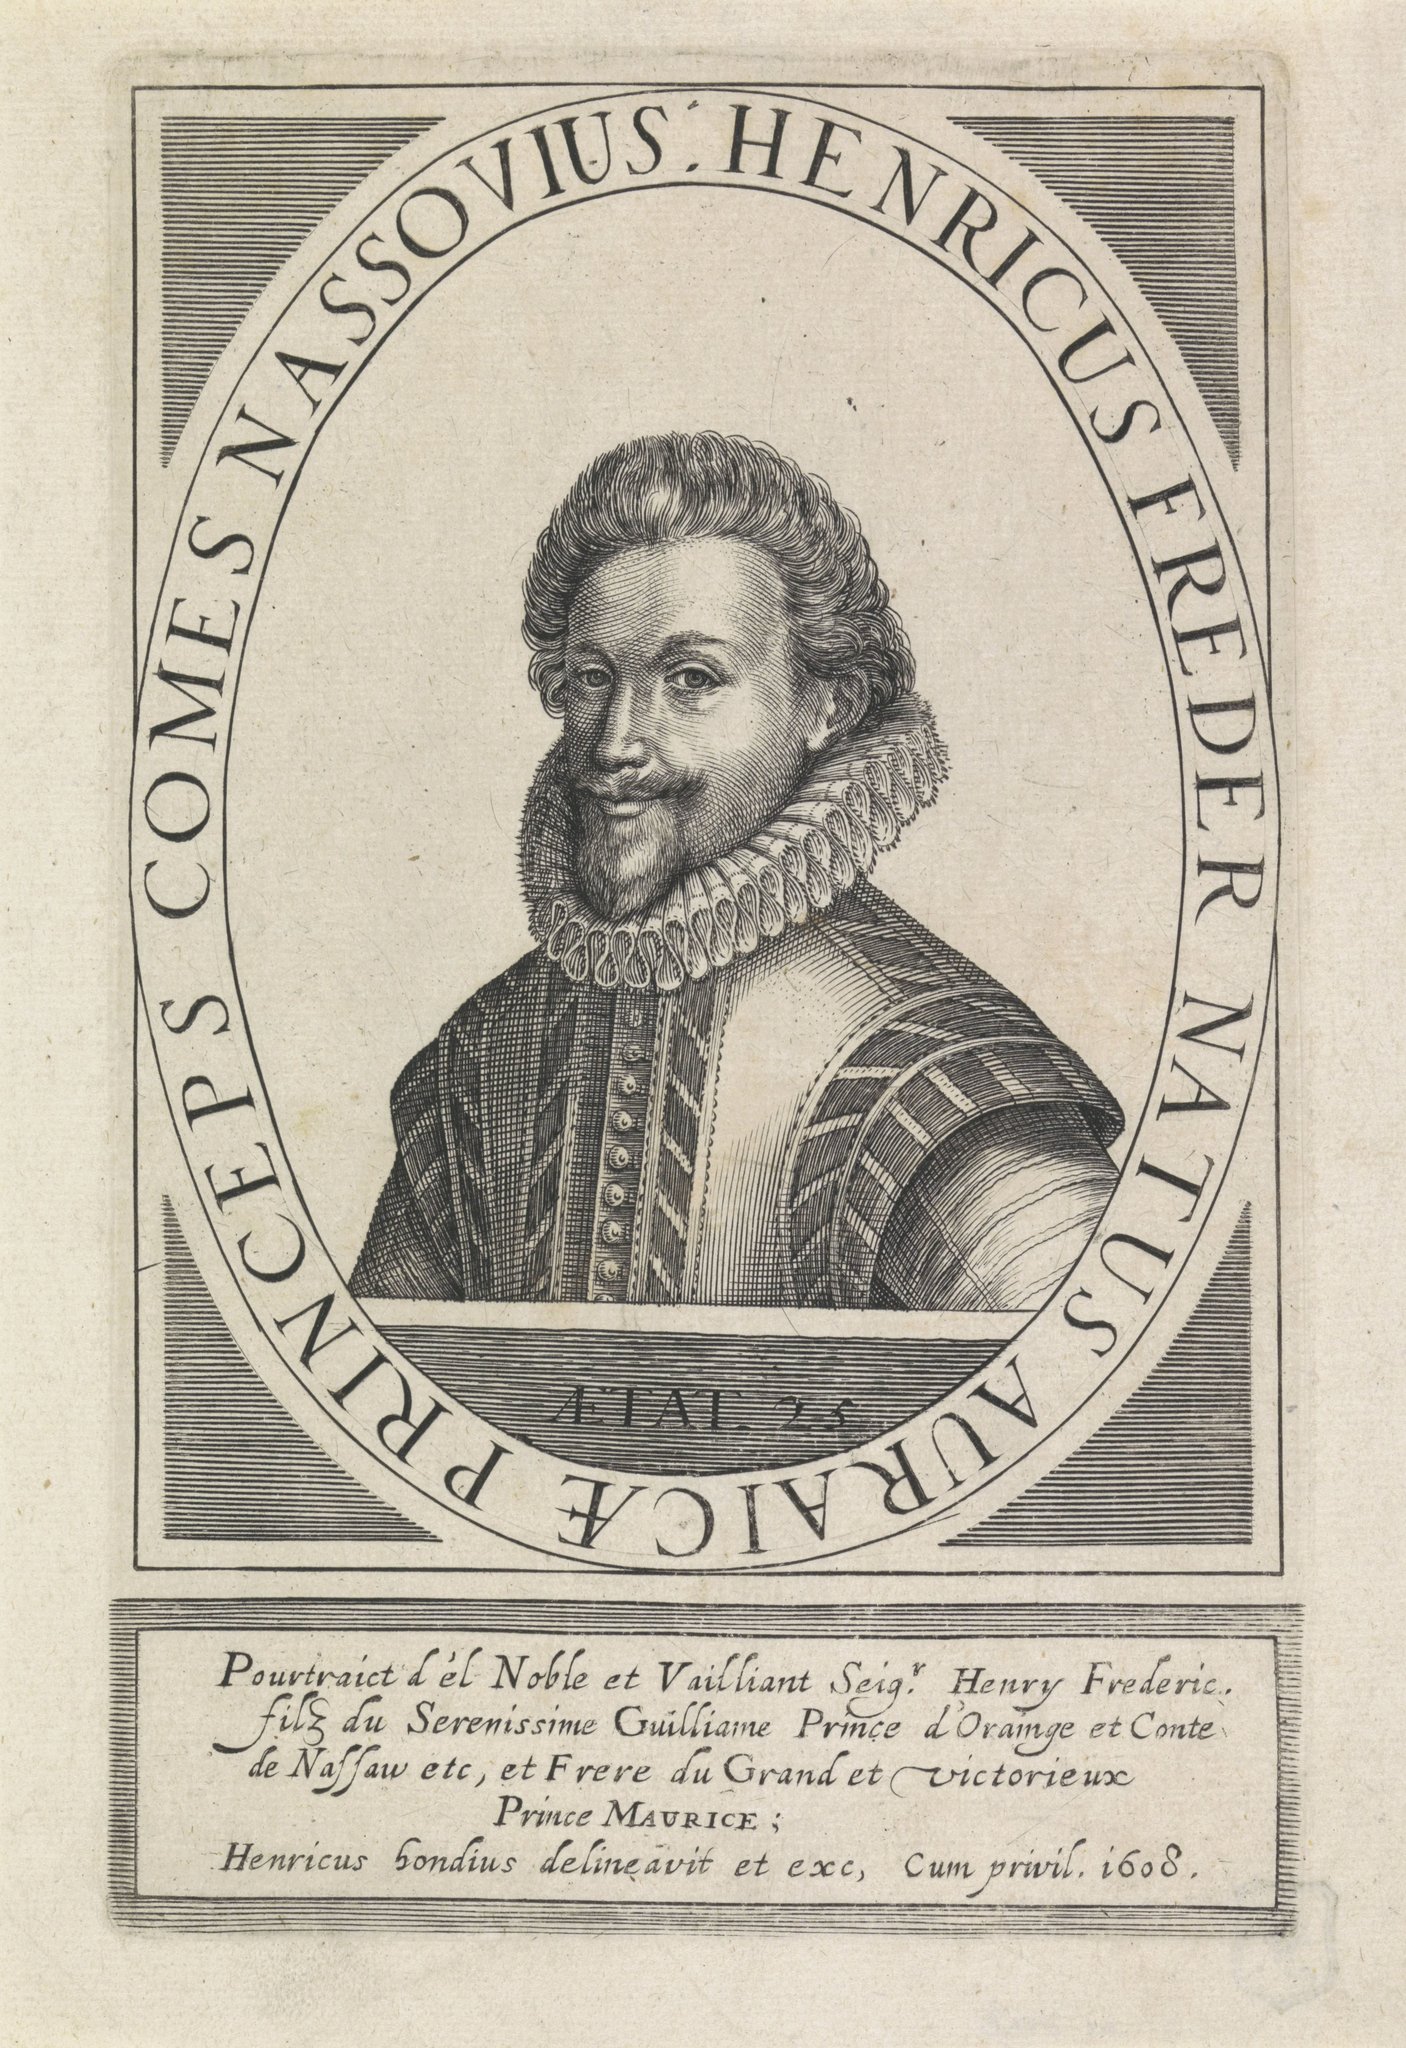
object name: print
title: Belgiae Pacificatorum Vera Delineatio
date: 1608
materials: paper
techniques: engraving, etching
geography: the hague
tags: delft, frederick henry (prince of orange)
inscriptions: collector's mark: Lugt 963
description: De hier vermelde titel verwijst naar de hoogst verkregen titel van de geportretteerde, niet per se naar de titel die de geportretteerde op deze voorstelling draagt.